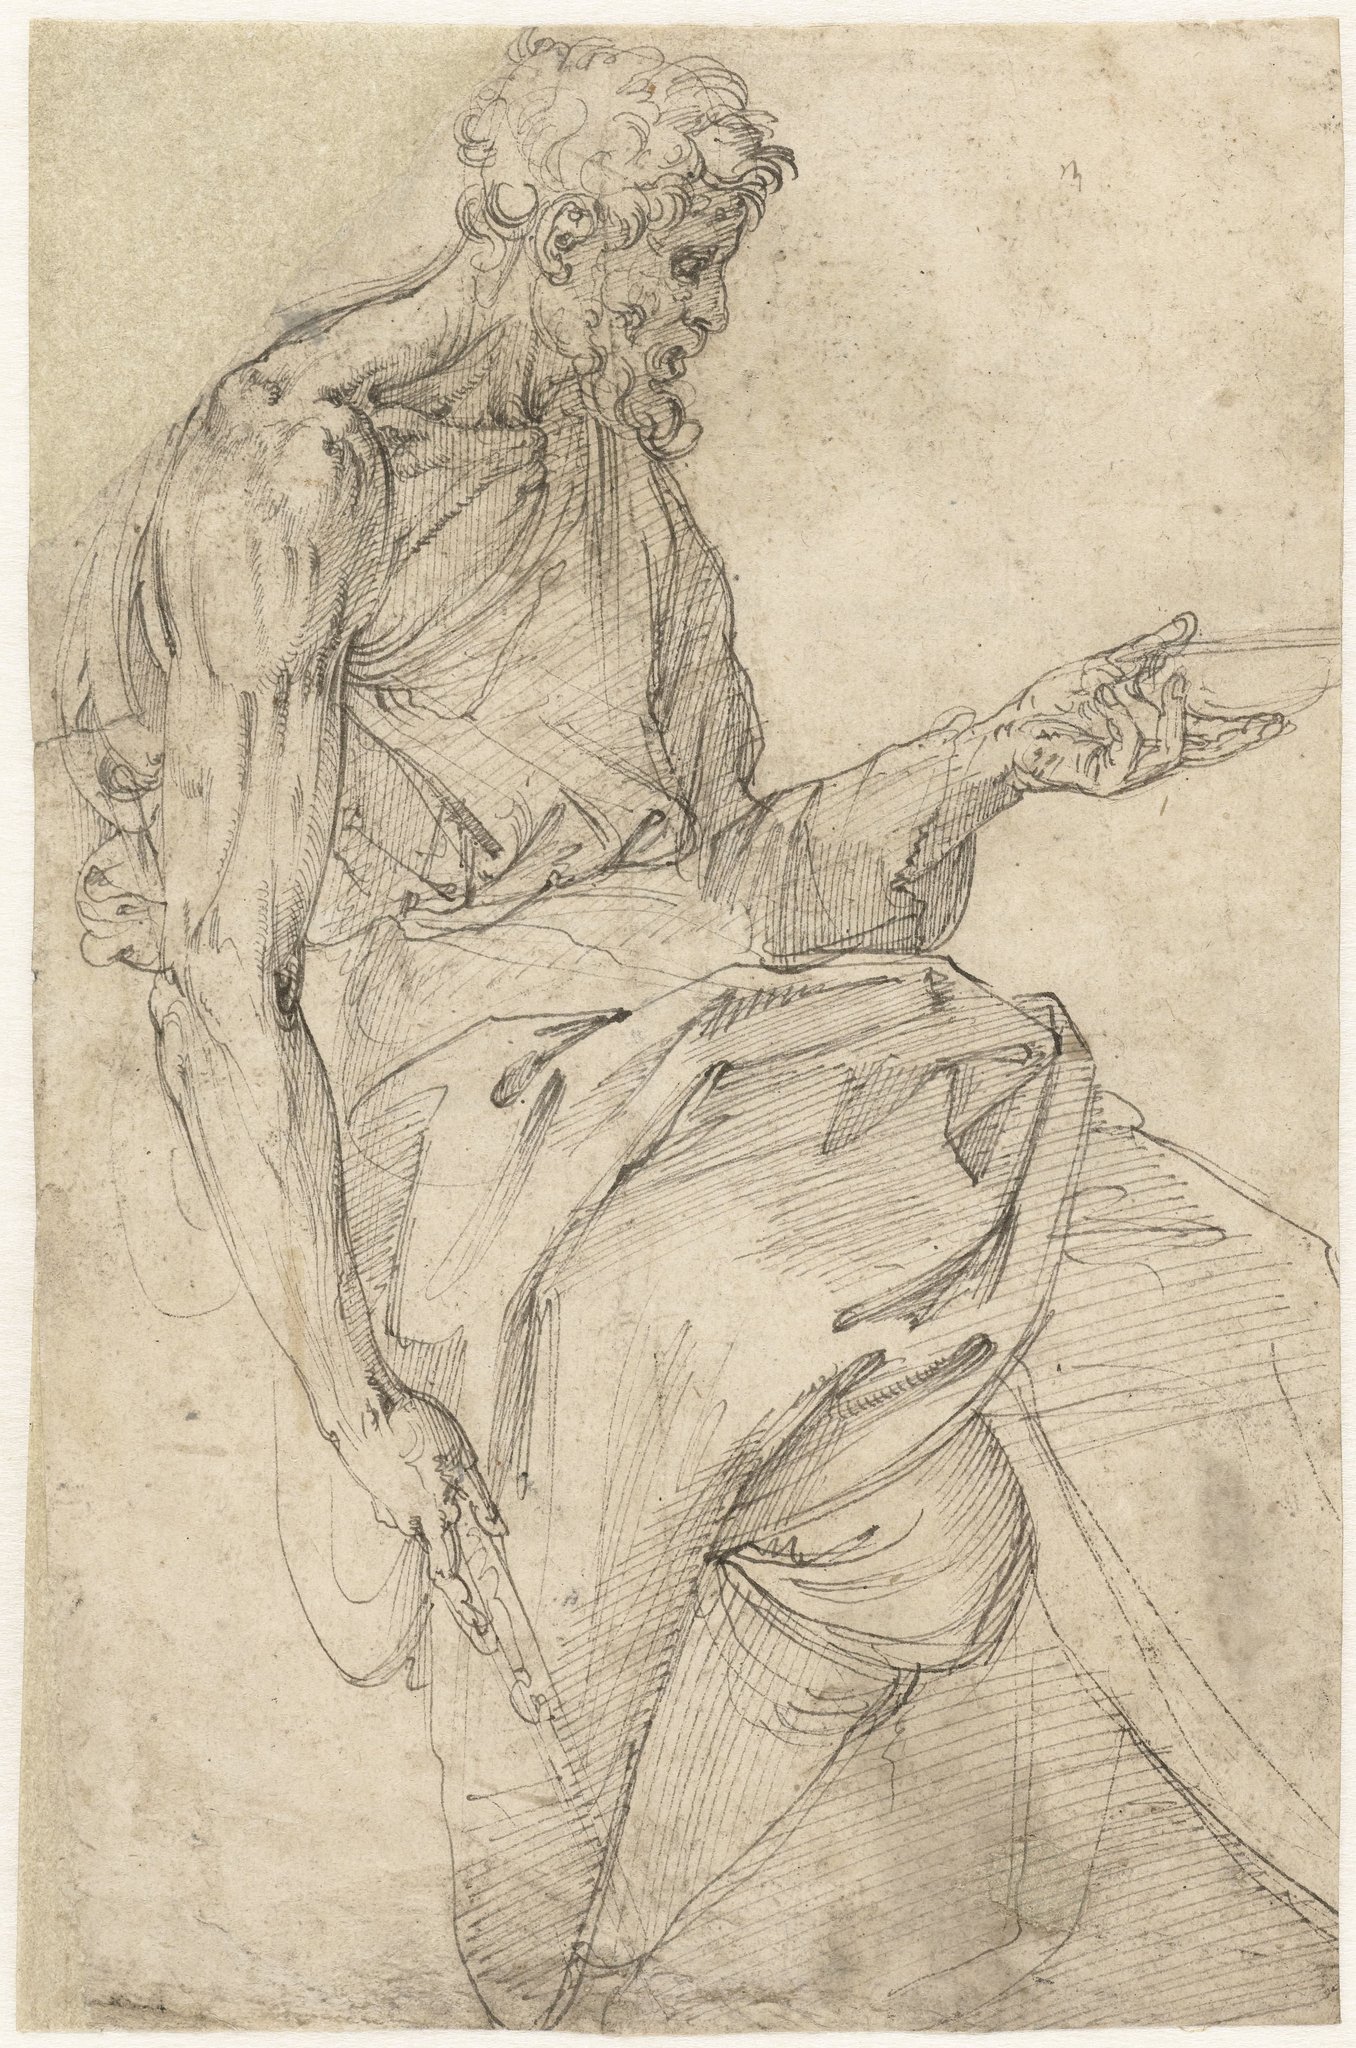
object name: drawing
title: Johannes de Doper zittend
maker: battista franco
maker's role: draughtsman, painter, print maker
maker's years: 1510-1561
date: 1520-1561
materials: ink, paper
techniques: pen